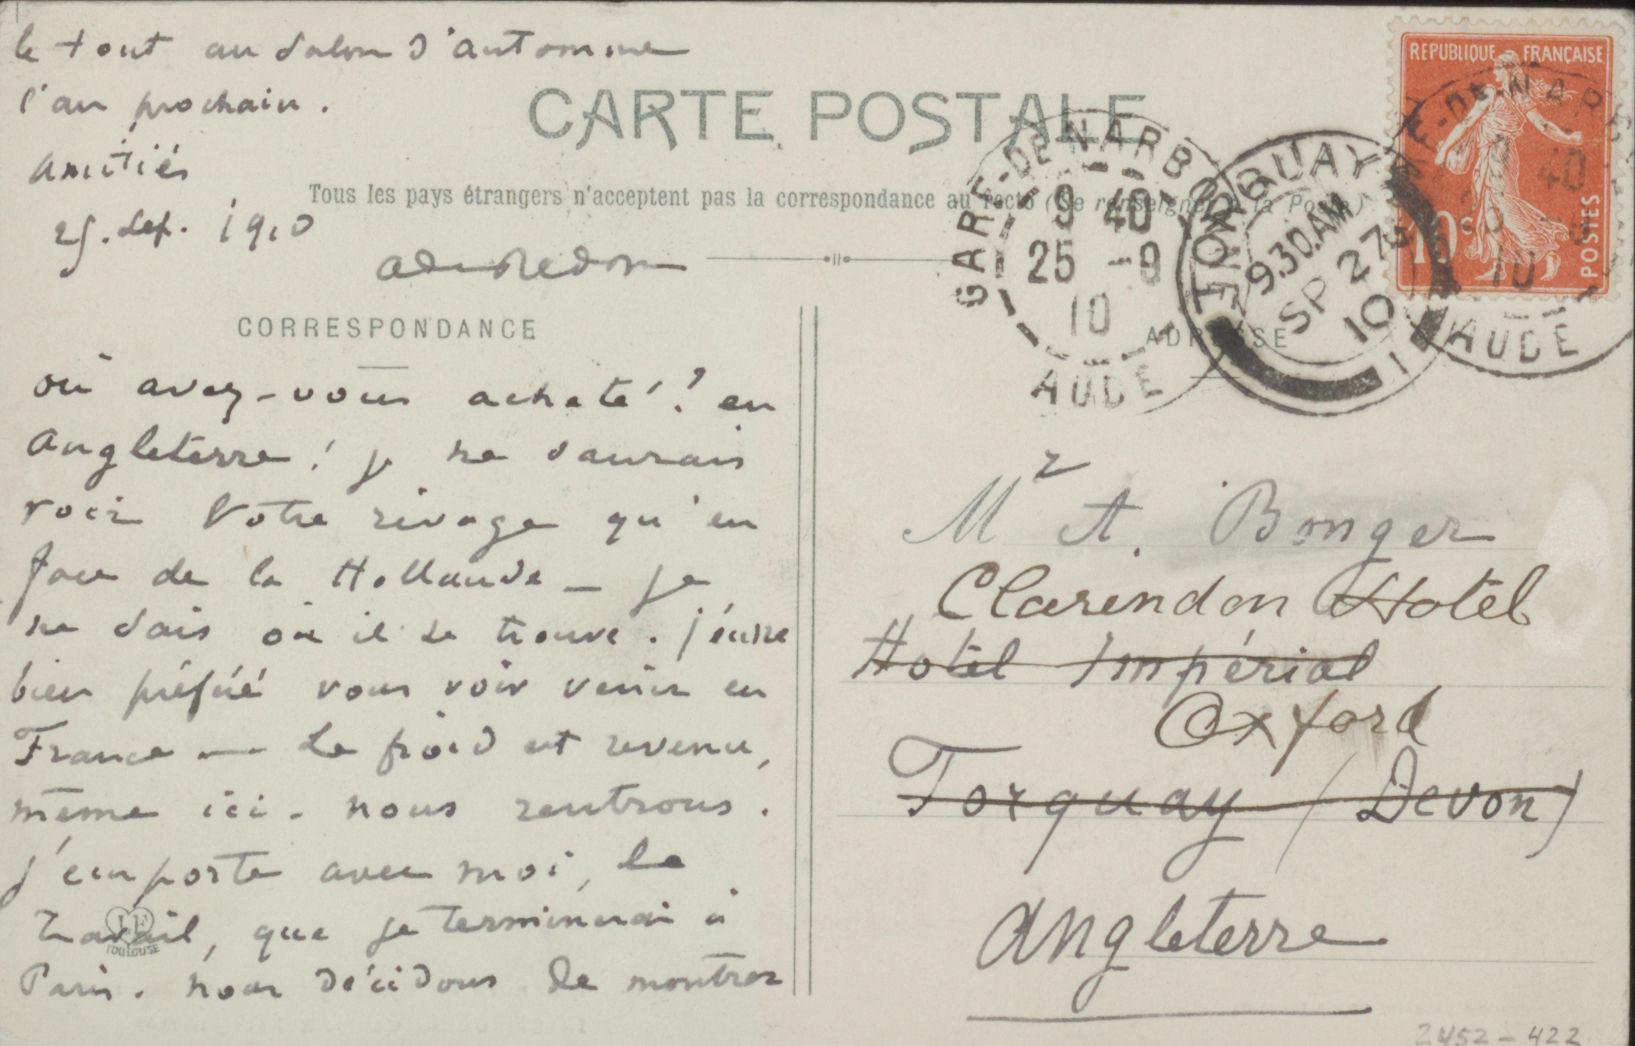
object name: ansichtkaart, prentbriefkaart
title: Prentbriefkaart aan Andries Bonger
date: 1910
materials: cardboard, ink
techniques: photograph, pen, writing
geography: toulouse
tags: amsterdam, andries bonger, exhibition ~ art, art collecting, paris, england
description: Prentbriefkaart behoort tot een album samengesteld door weduwe Françoise W.M. Barones van der Borch van Verwolde met afschriften van brieven met betrekking tot (de familie van) Odilon Redon. De prentbriefkaart werd bewaard op pagina 164.